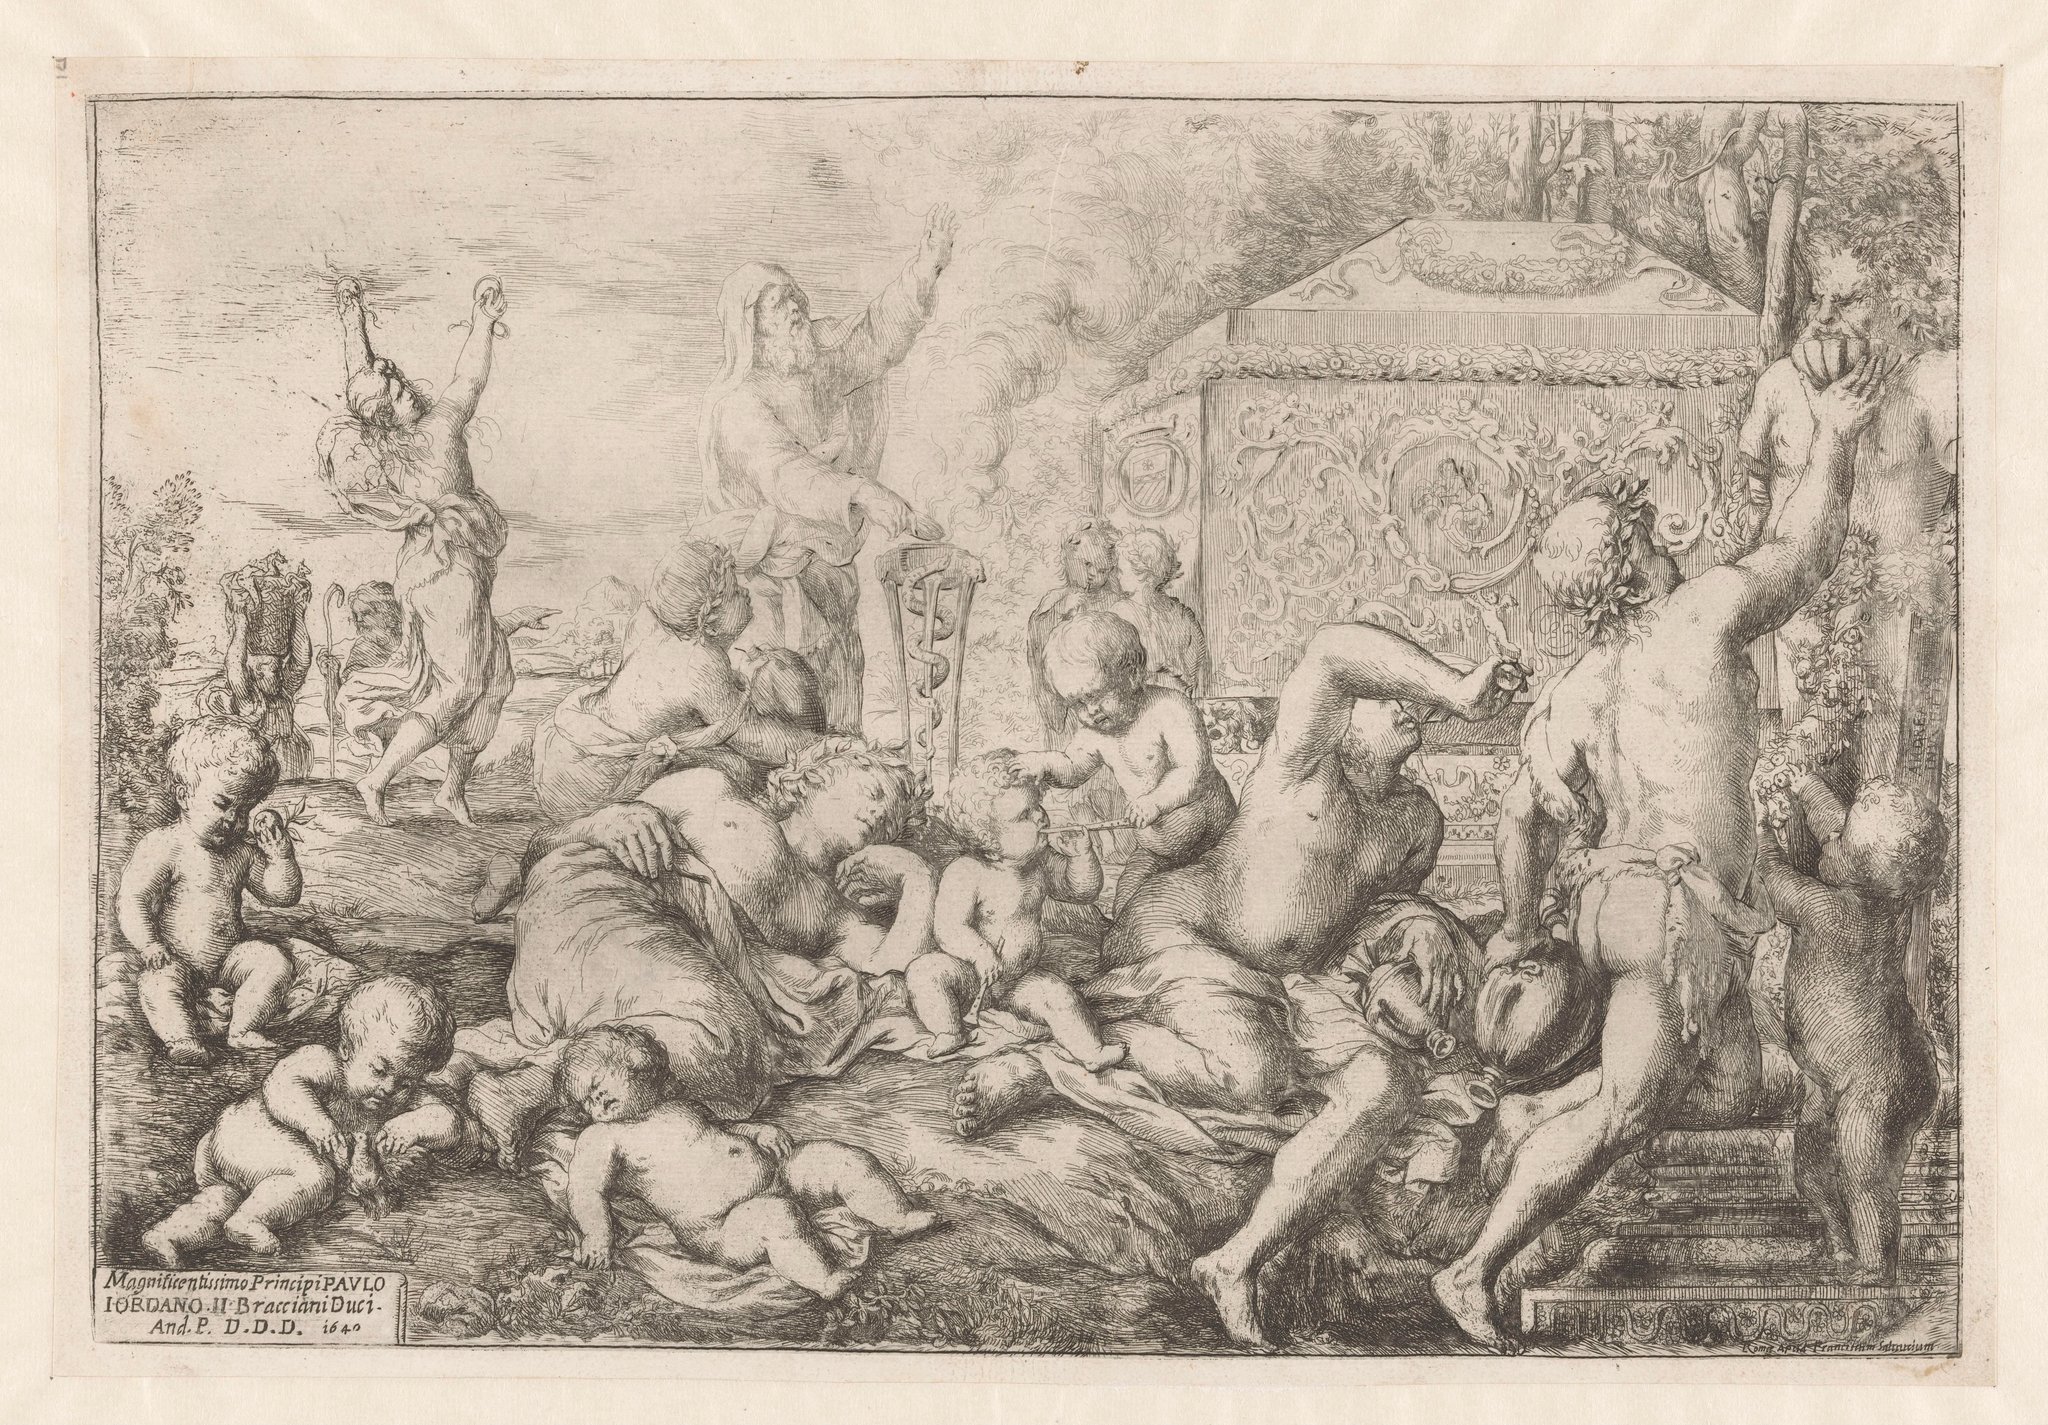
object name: print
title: Bacchanaal met altaar, faun en Silenus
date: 1640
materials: paper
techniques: etching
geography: italy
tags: bacchanal: bacchus with his wine-flushed train (thiasos), (story of) silenus, drunkenness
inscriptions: collector's mark: Lugt 240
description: Een bacchanaal in een landschap met putti, bacchanten en de slapende Silenus. Een priester staat bij een altaar en maakt een offer. Op de achtergrond rechts een grote sarcofaag.